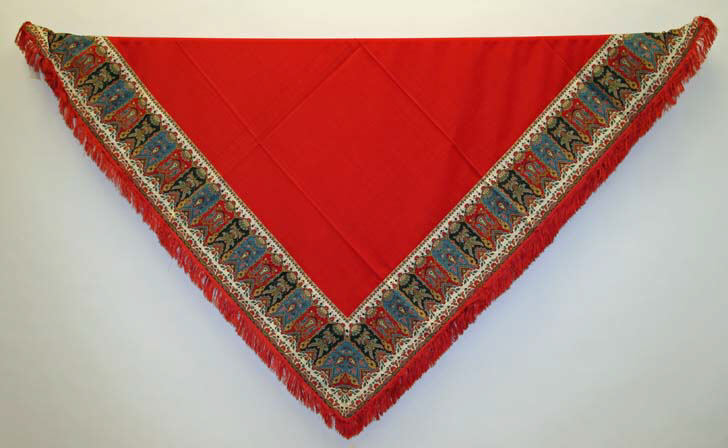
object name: shawl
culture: russian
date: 1840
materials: silk, wool